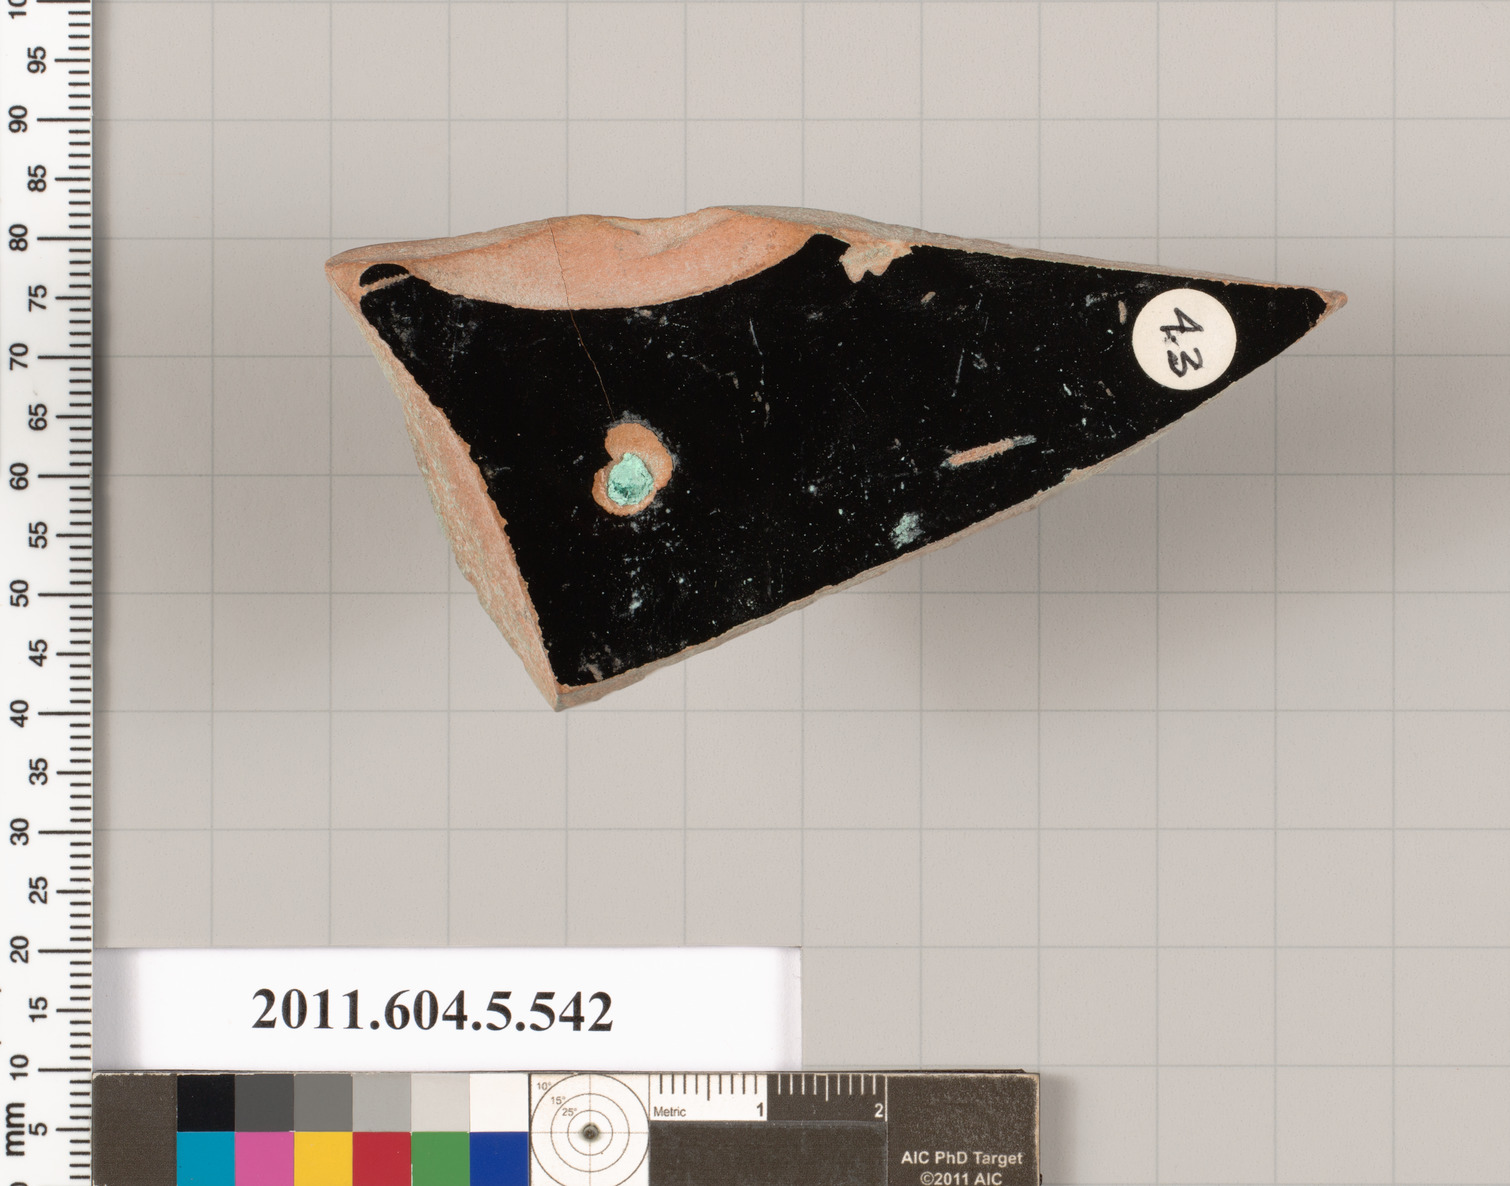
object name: kylix fragment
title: Terracotta fragment of a kylix (drinking cup)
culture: greek, attic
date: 600-401 BCE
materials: terracotta